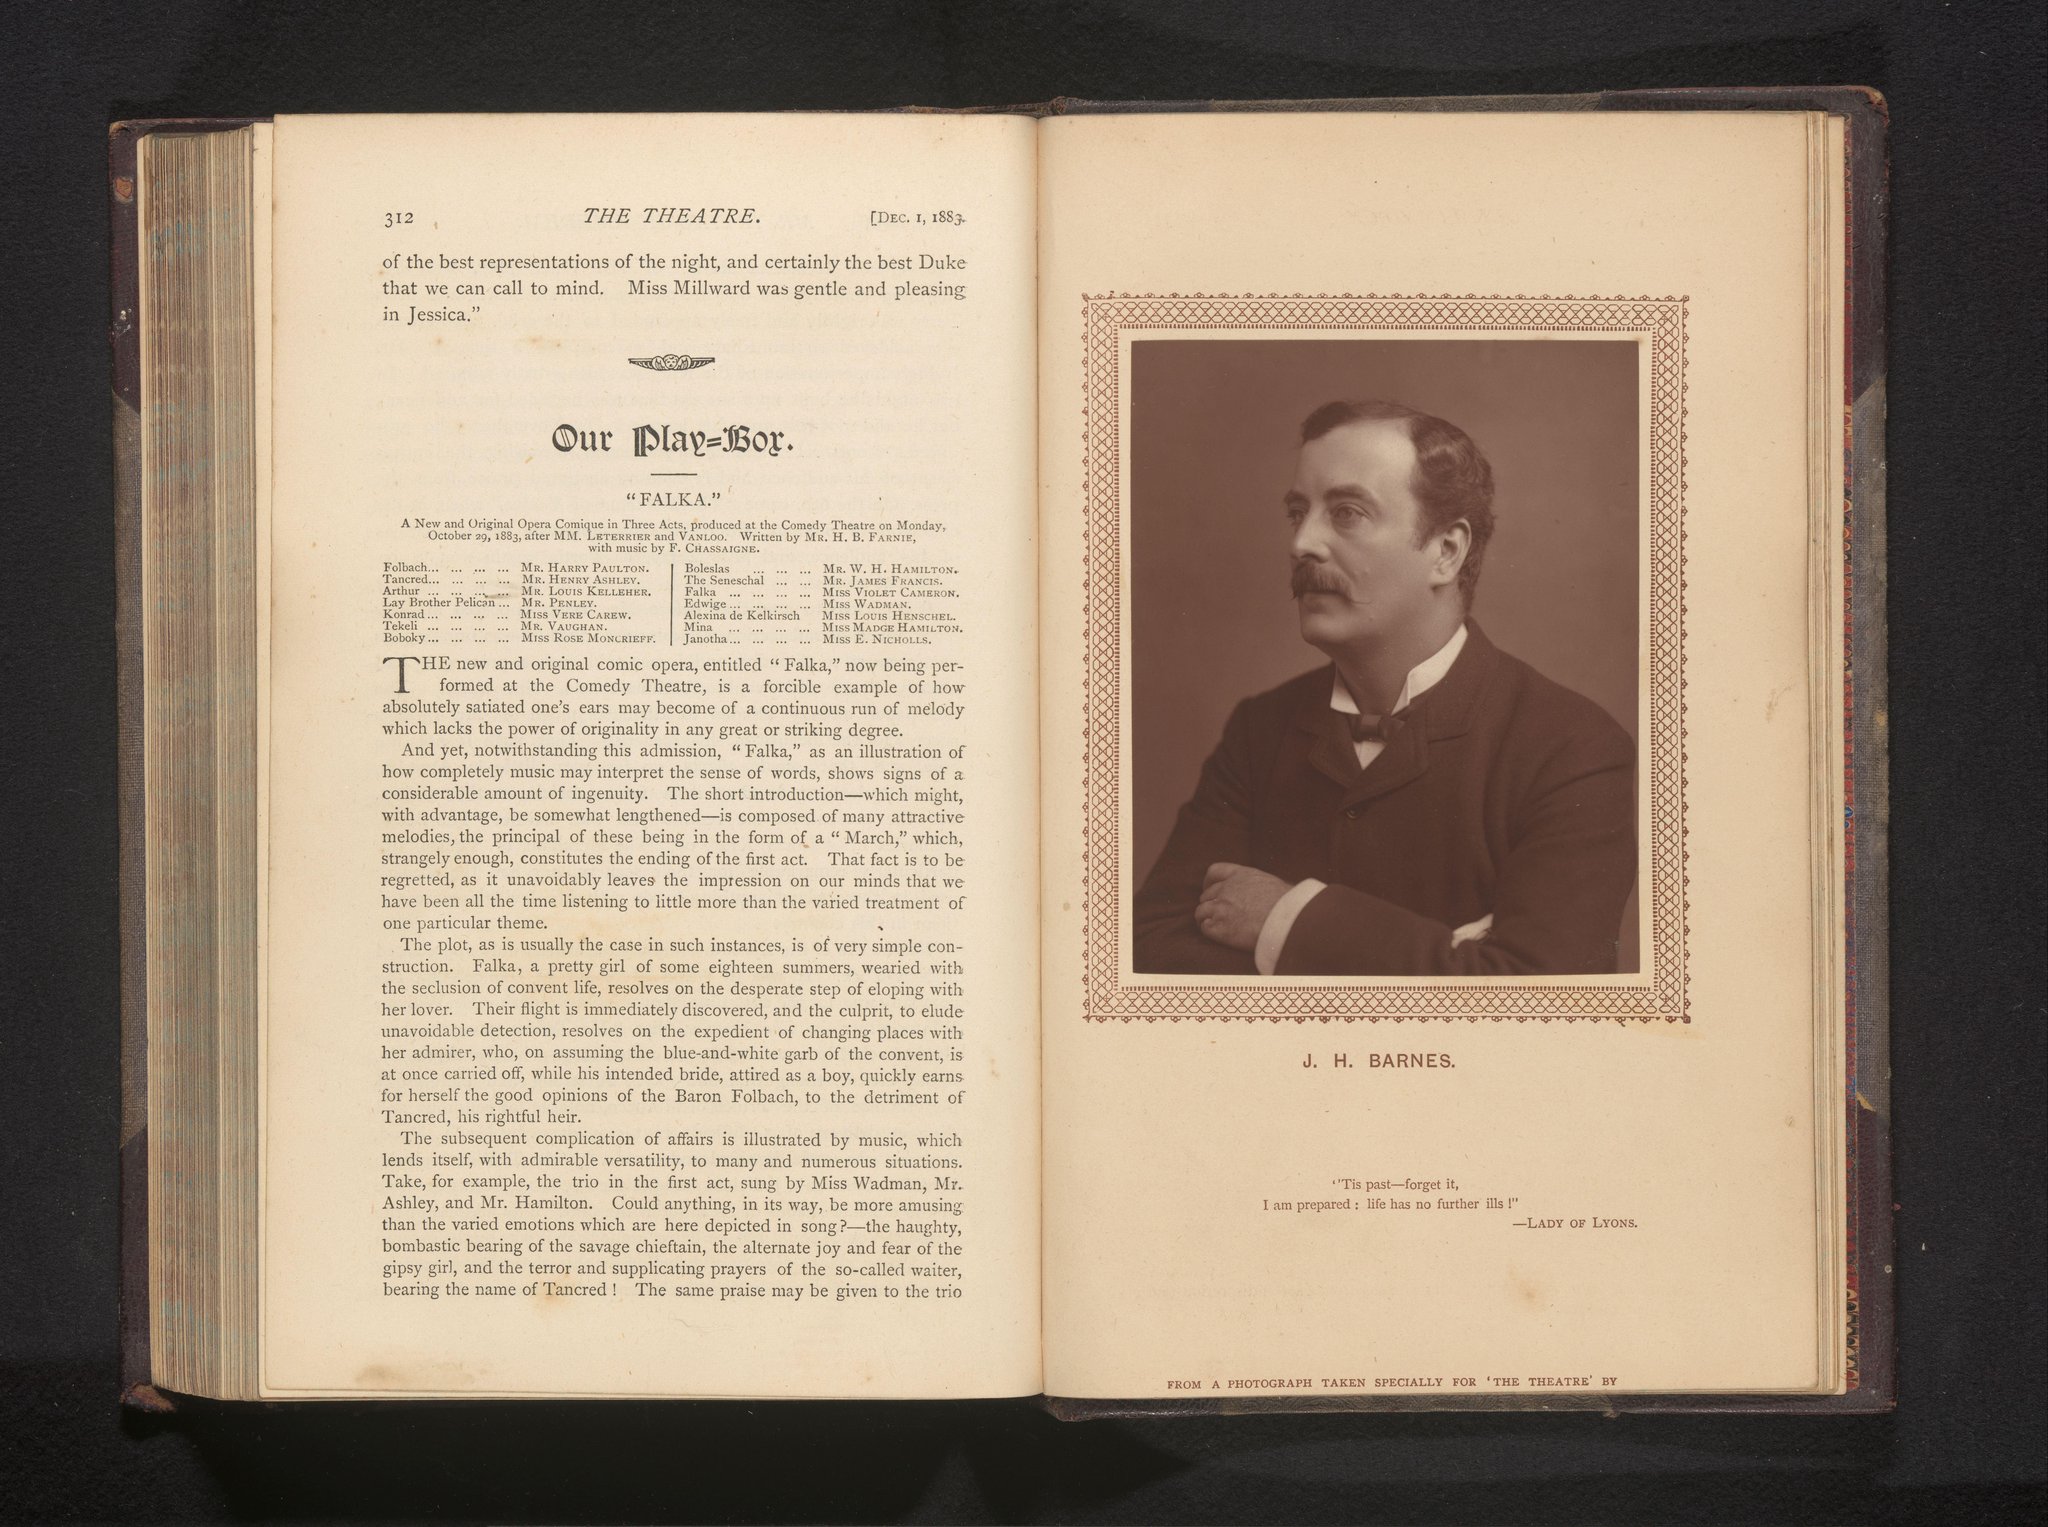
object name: page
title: Portret van J. H. Barnes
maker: Anonymous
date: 1878-1883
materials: paper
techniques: woodburytype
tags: adult man, historical persons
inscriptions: inscription: ‘'Tis past - forget it,/ I am prepared : life has no further ills! / - Lady of Lyons’